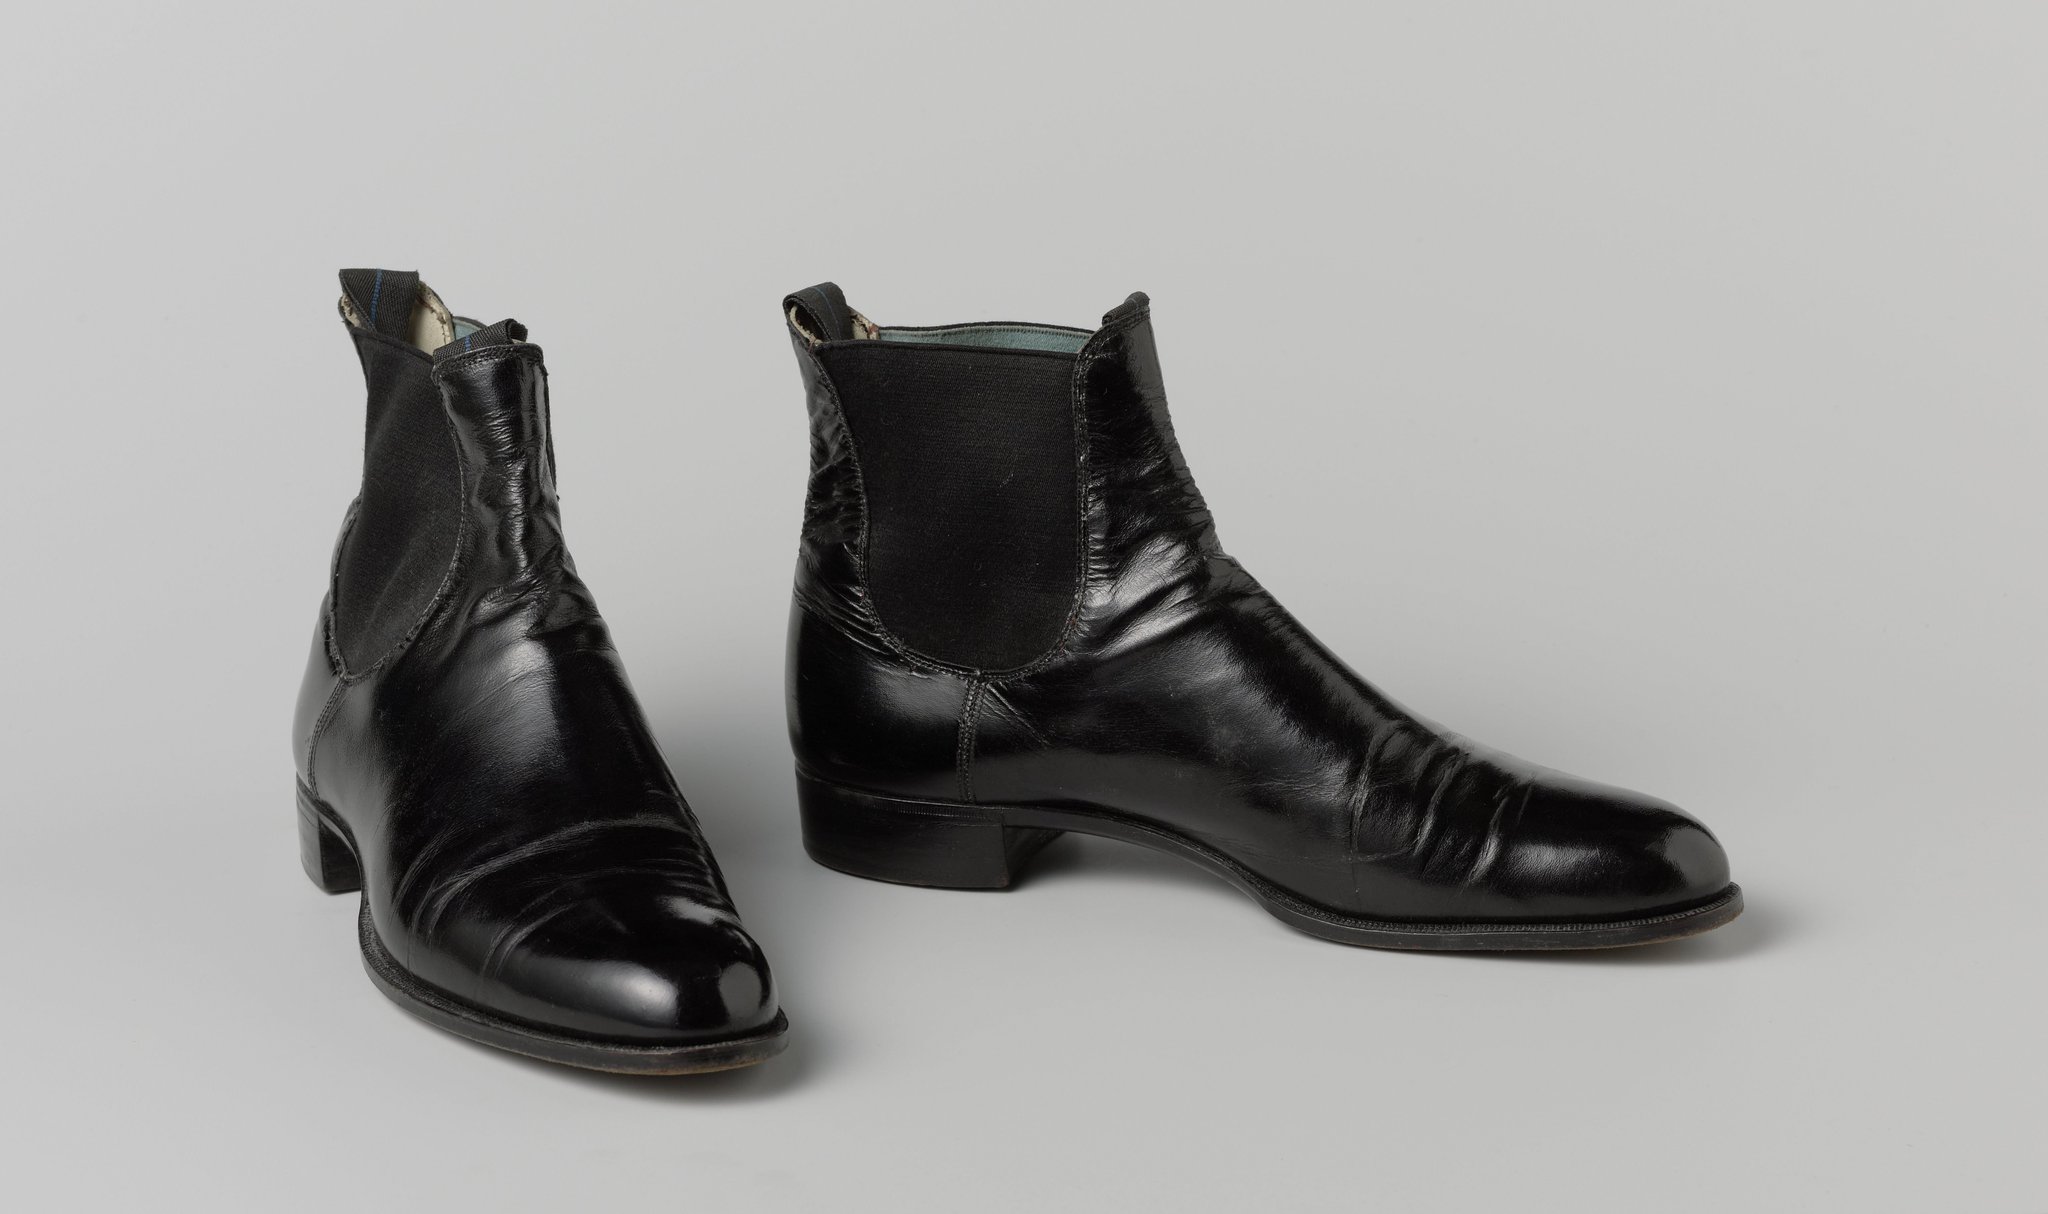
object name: shoe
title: Bottine van ambassadeur Allard Merens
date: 1940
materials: iron, leather, rubber, textile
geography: china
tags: the hague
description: Laklederen bottine. Behorend bij de diplomatieke ambtskleding van ambassadeur Allard Merens.